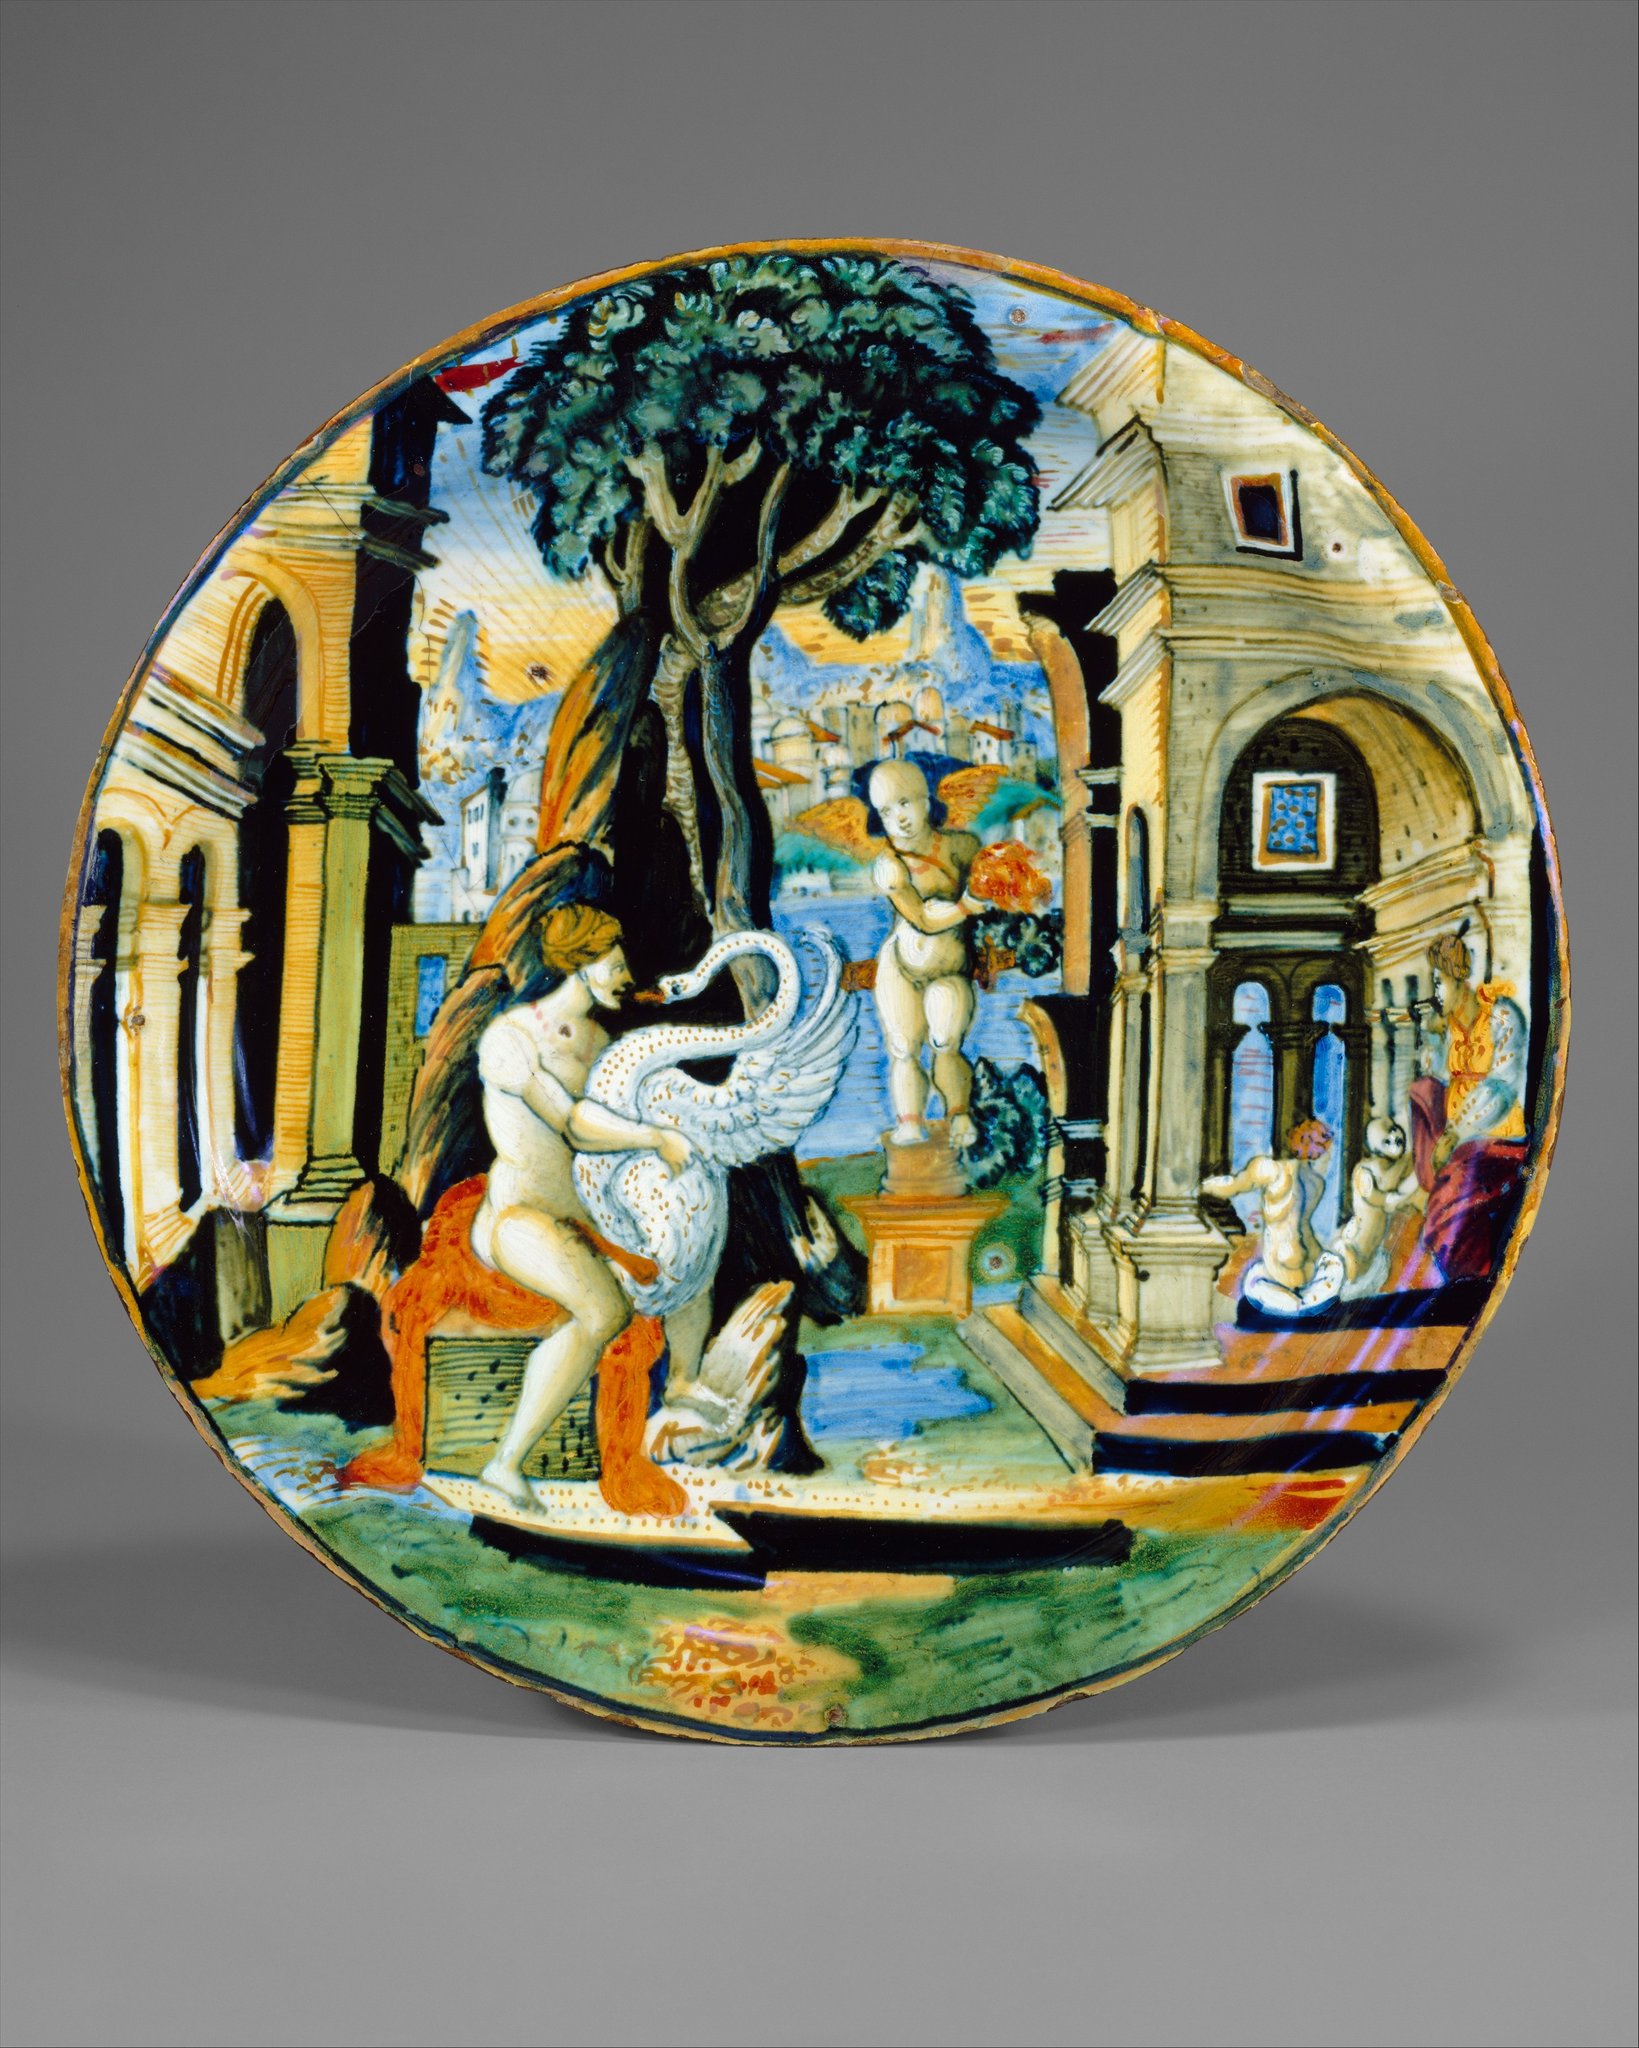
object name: plate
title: Plate (scodella)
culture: italian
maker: workshop of guido durantino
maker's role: artist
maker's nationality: italian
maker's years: 1516-1581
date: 1530-1540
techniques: maiolica, glazing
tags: cupid,leda,swans